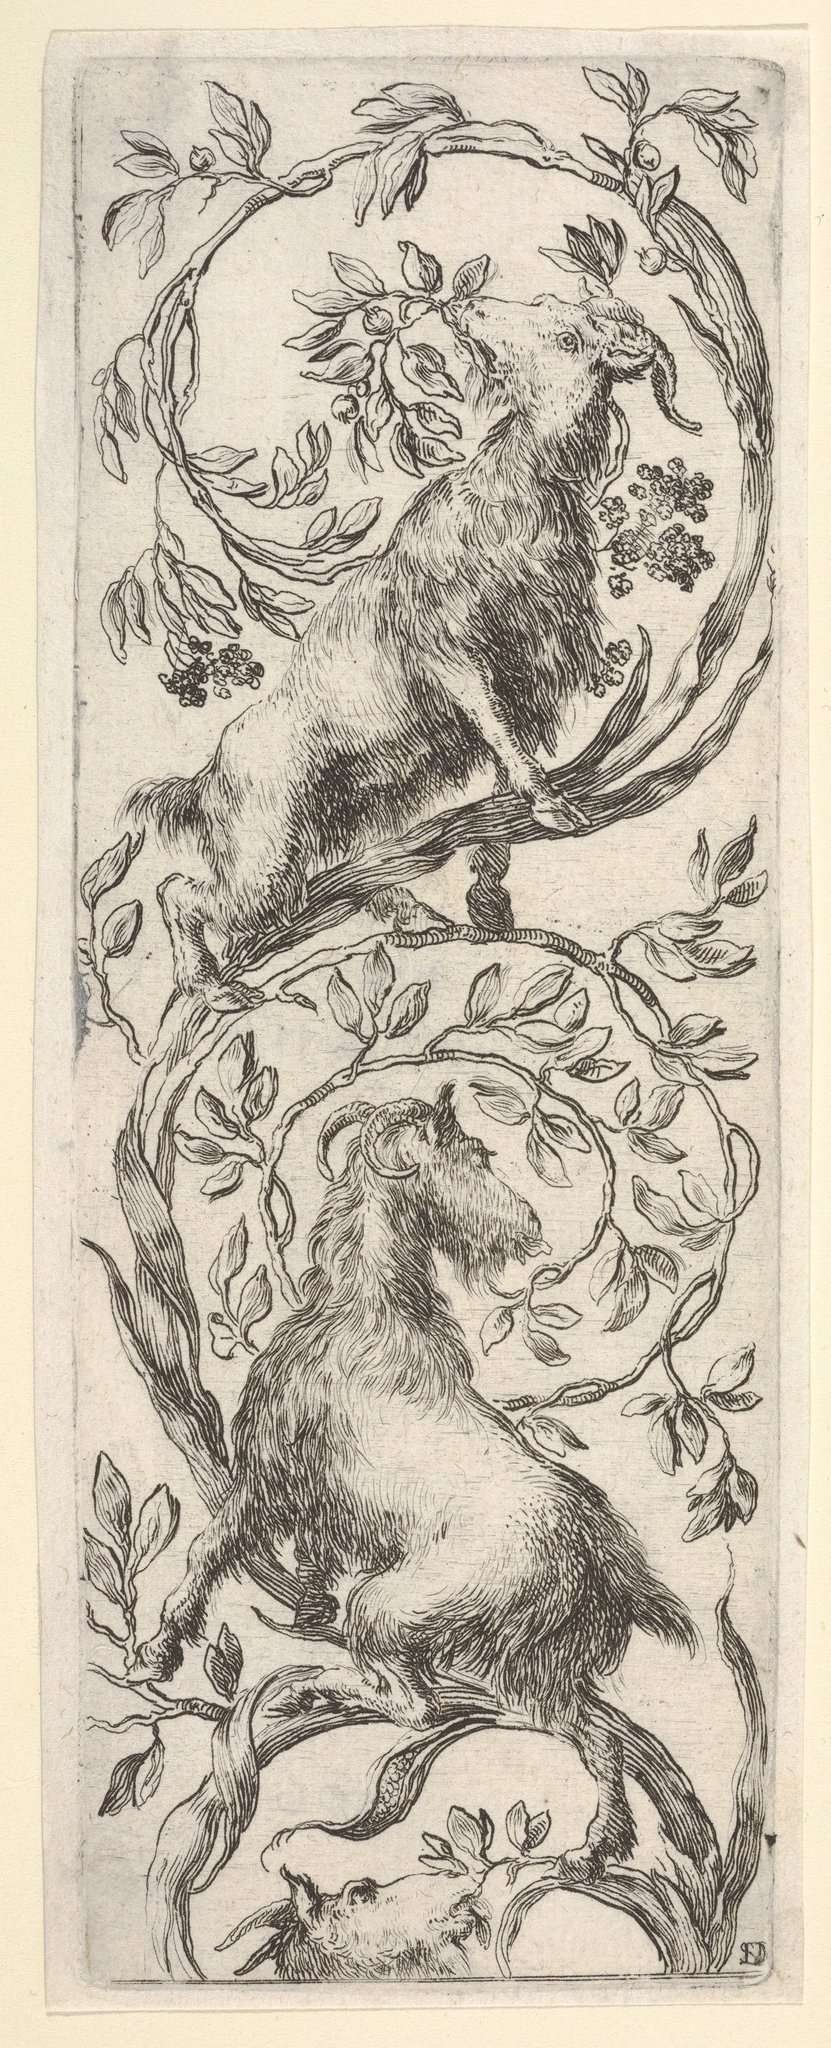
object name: print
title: Three goats climbing a vine in the shape of a backwards 'S', from "Ornaments or Grotesques" (Ornamenti o Grottesche)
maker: stefano della bella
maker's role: artist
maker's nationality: italian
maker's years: 1610-1664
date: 1650-1656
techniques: etching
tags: goats,leaves